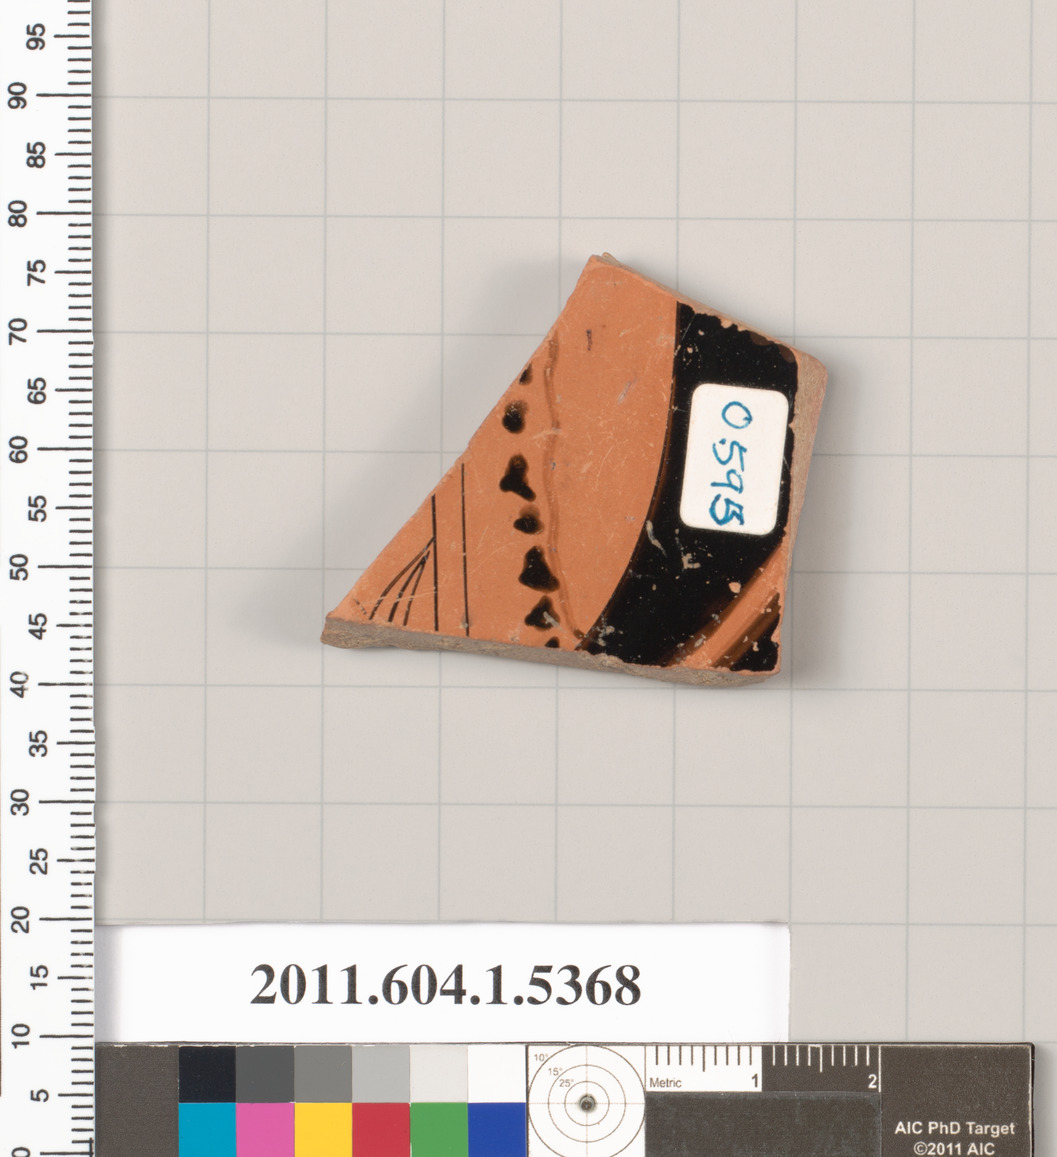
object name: kylix fragment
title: Terracotta fragment of a kylix (drinking cup)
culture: greek, attic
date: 500-480 BCE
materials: terracotta